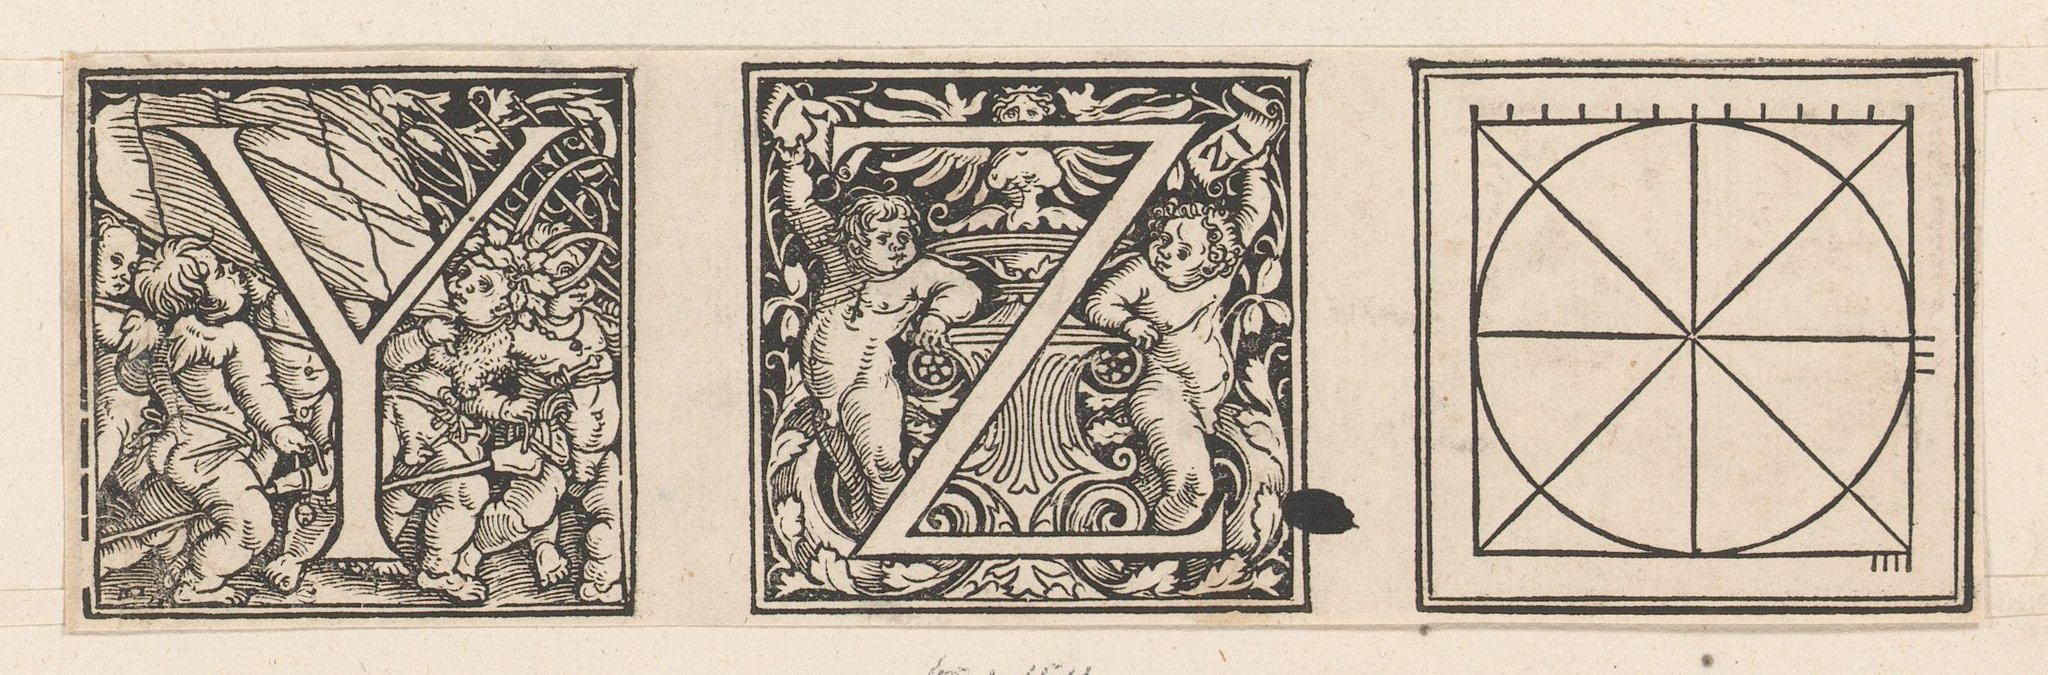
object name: book illustration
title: Initialen Y, Z en geometrische figuur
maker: jost de negker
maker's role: print maker, printer, publisher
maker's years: 1485-1544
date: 1521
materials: paper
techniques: woodcut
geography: augsburg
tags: initial, cupids: 'amores', 'amoretti', 'putti'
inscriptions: date